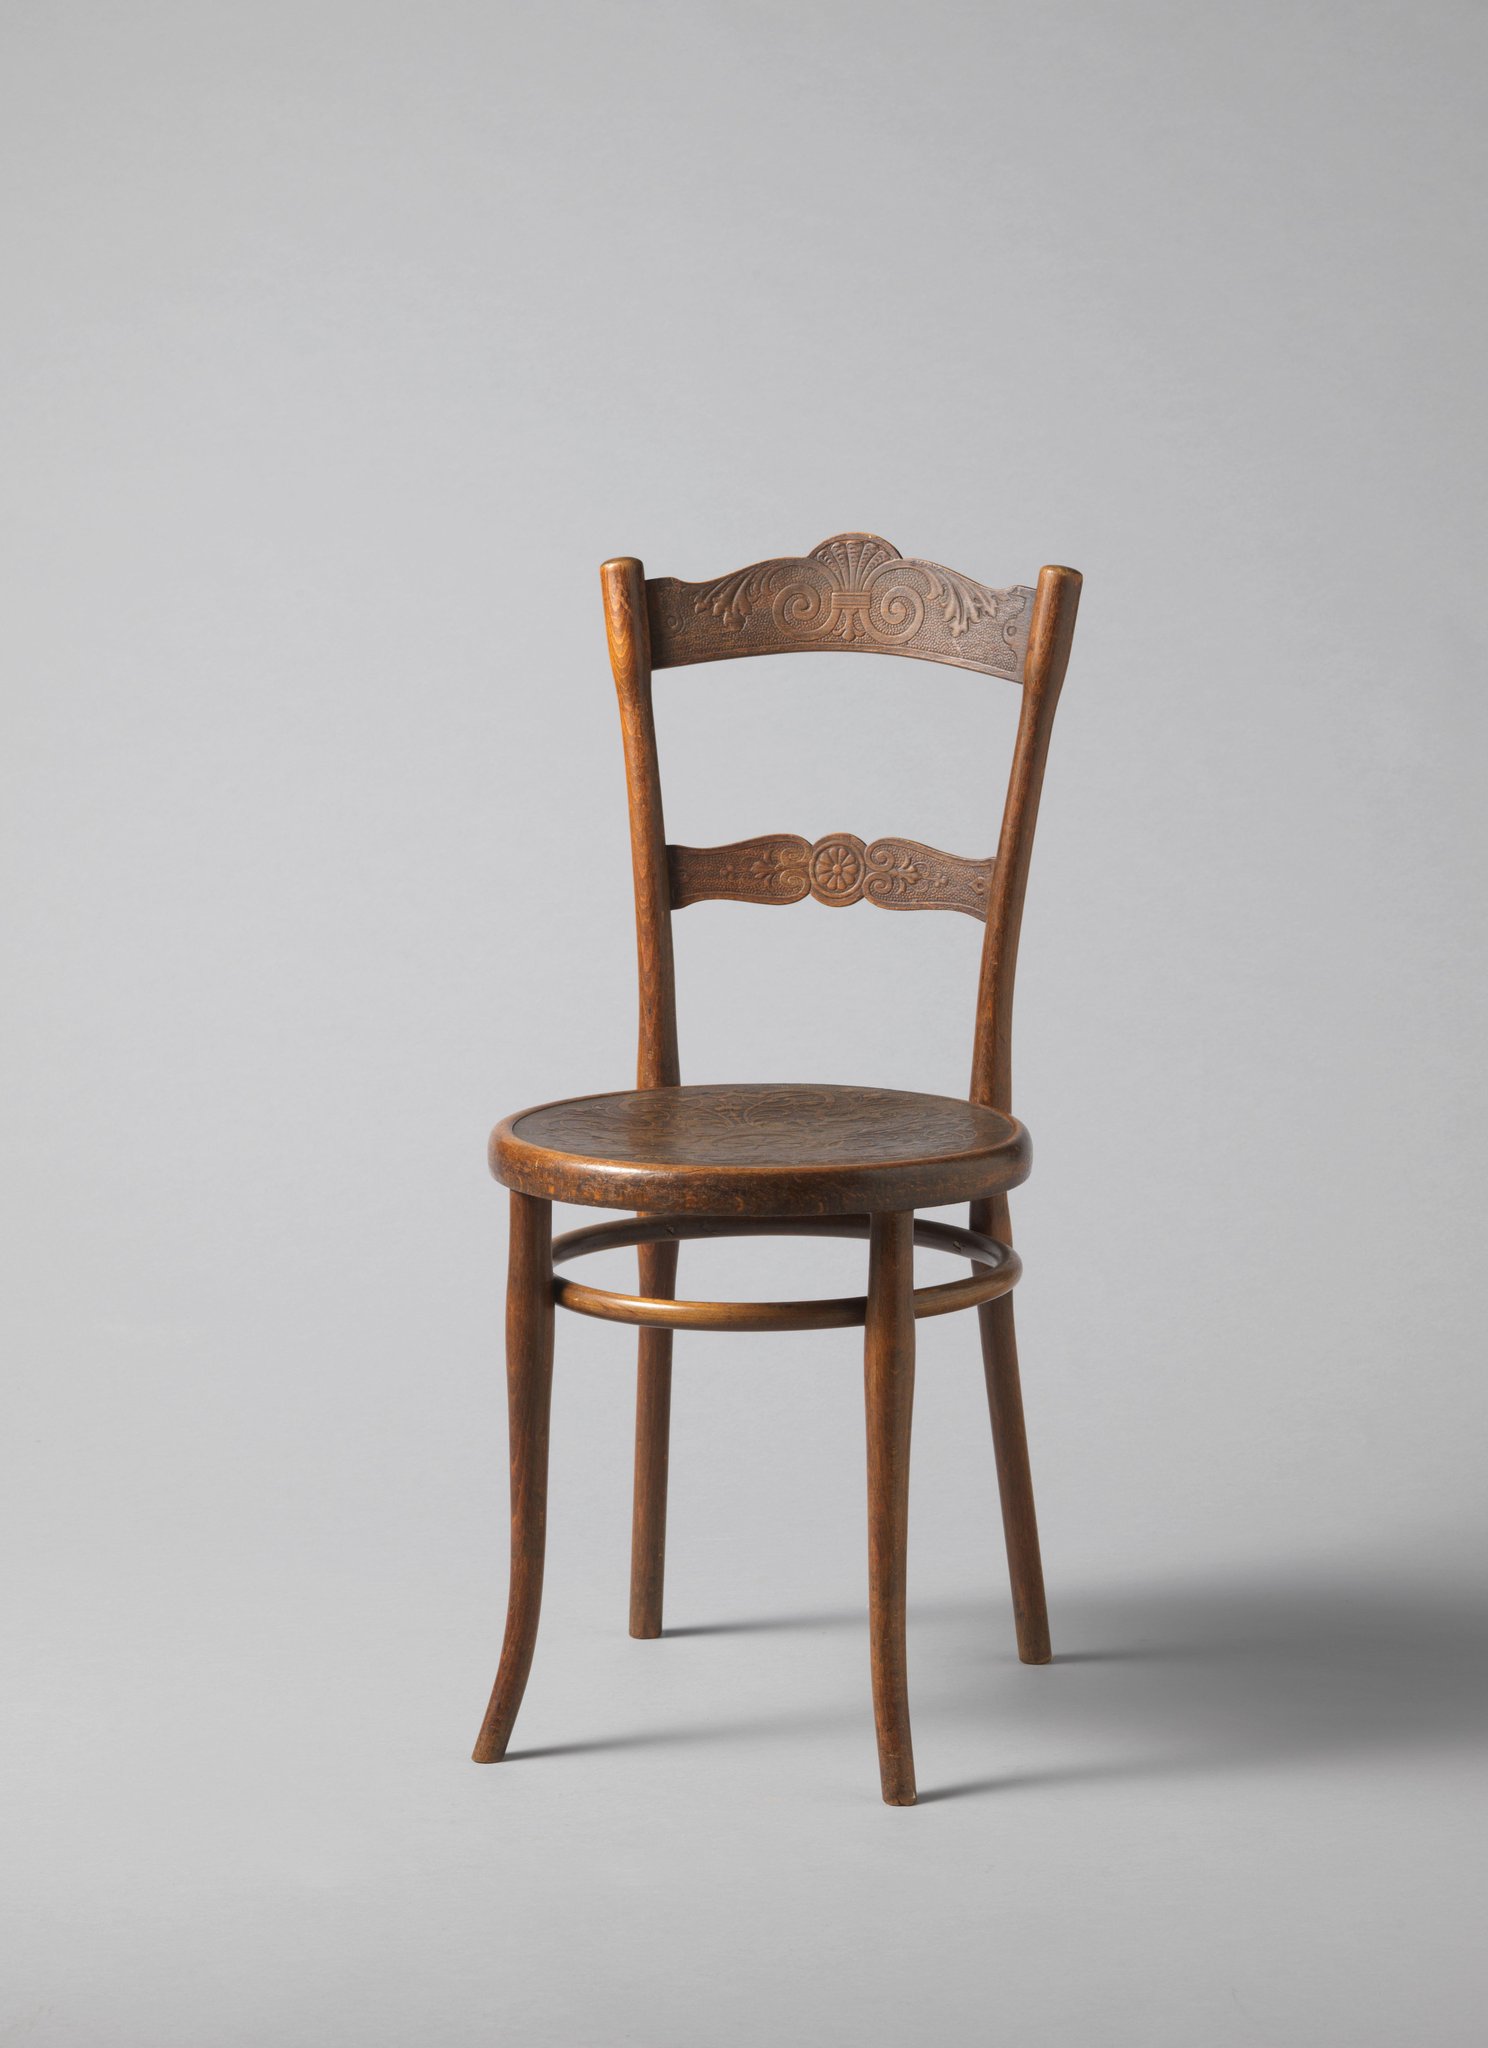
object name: chair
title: Meubilair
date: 1900-1987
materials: wood, iron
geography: germany